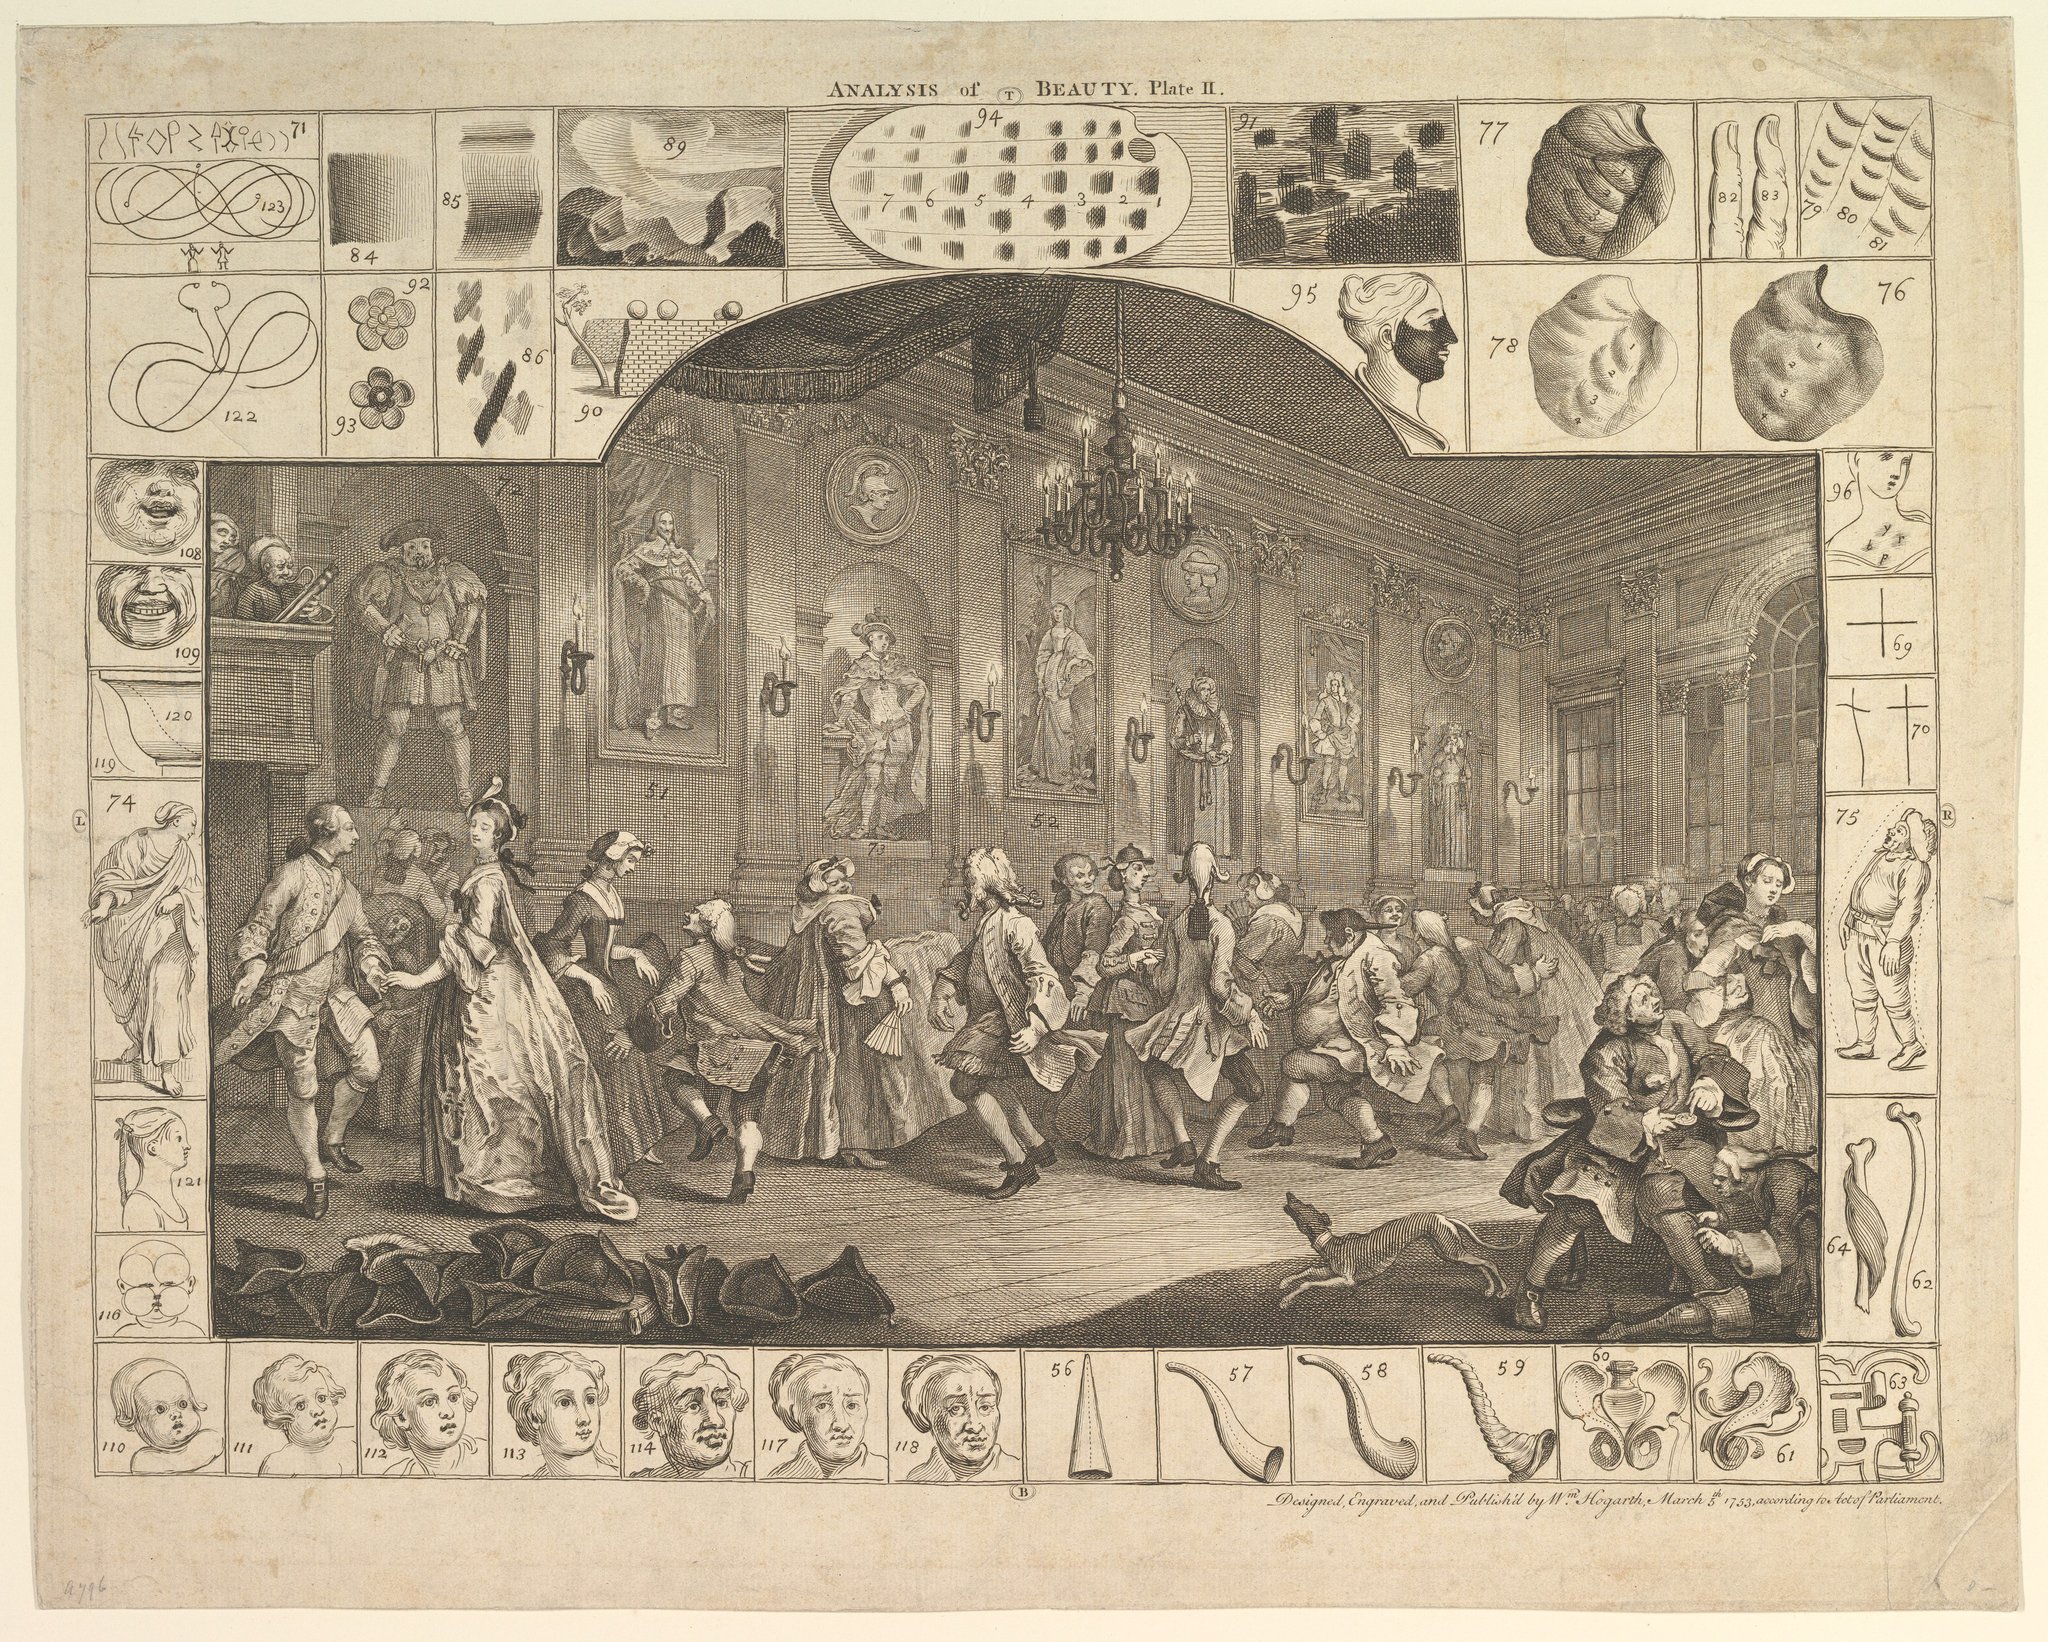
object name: print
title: Analysis of Beauty, Plate 2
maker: william hogarth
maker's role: artist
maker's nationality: british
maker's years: 1697-1764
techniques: engraving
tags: men,women,dancing